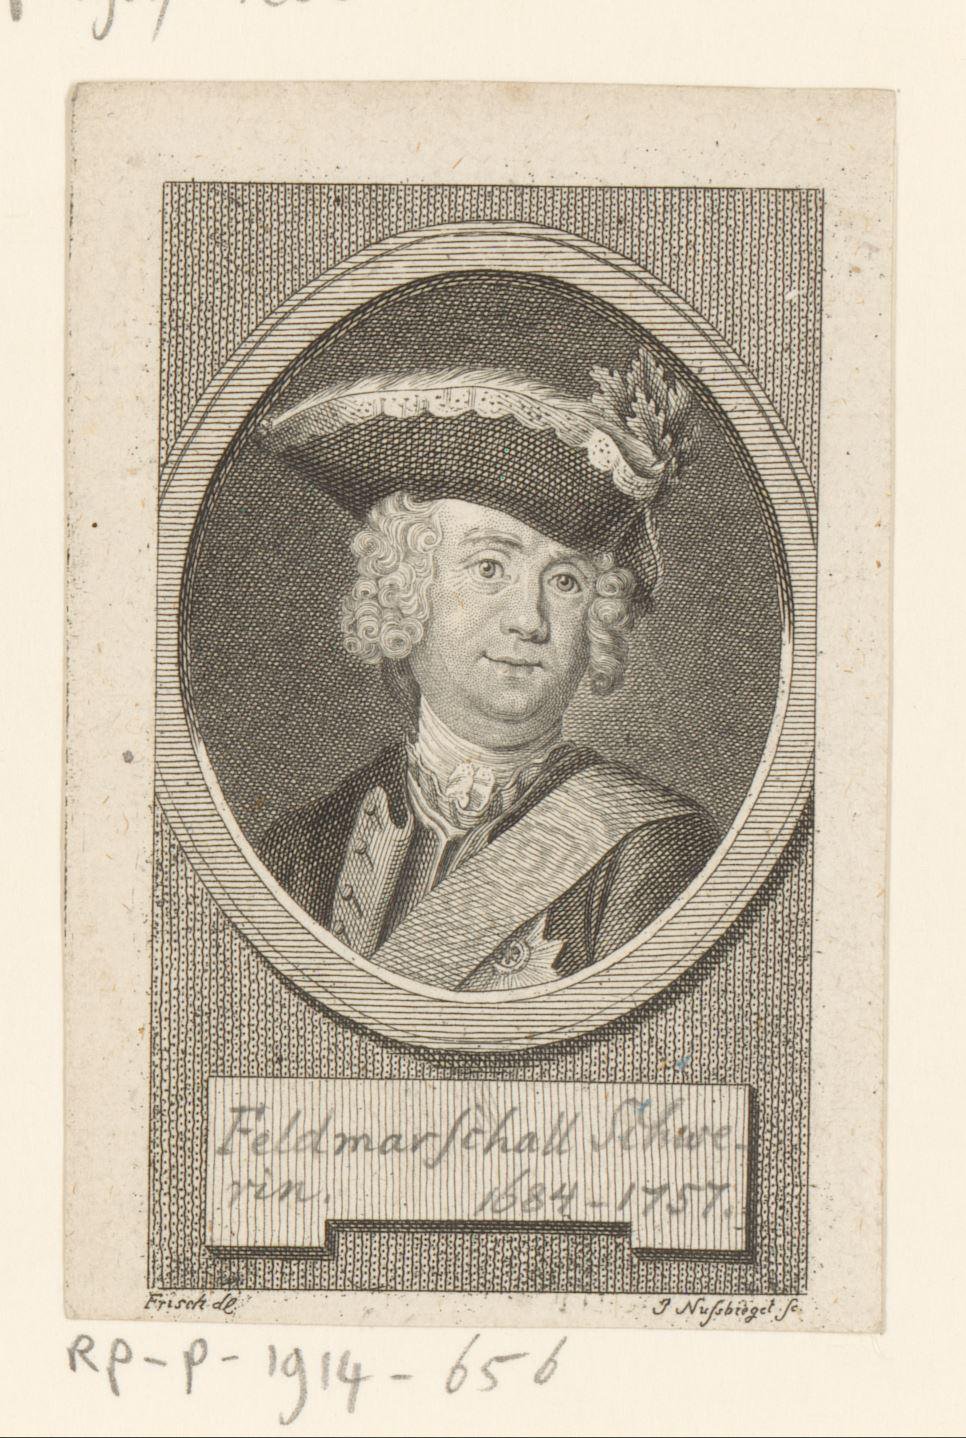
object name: print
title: Portret van Kurd Christoph von Schwerin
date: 1760-1829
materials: paper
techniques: engraving, etching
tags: prague, knighthood order (with name) - insignia of a knighthood order, e.g.: badge, chain (with name of order), historical persons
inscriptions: collector's mark: Lugt 2228, name: ‘Feldmarschall Schwerin. 1684-1757.’